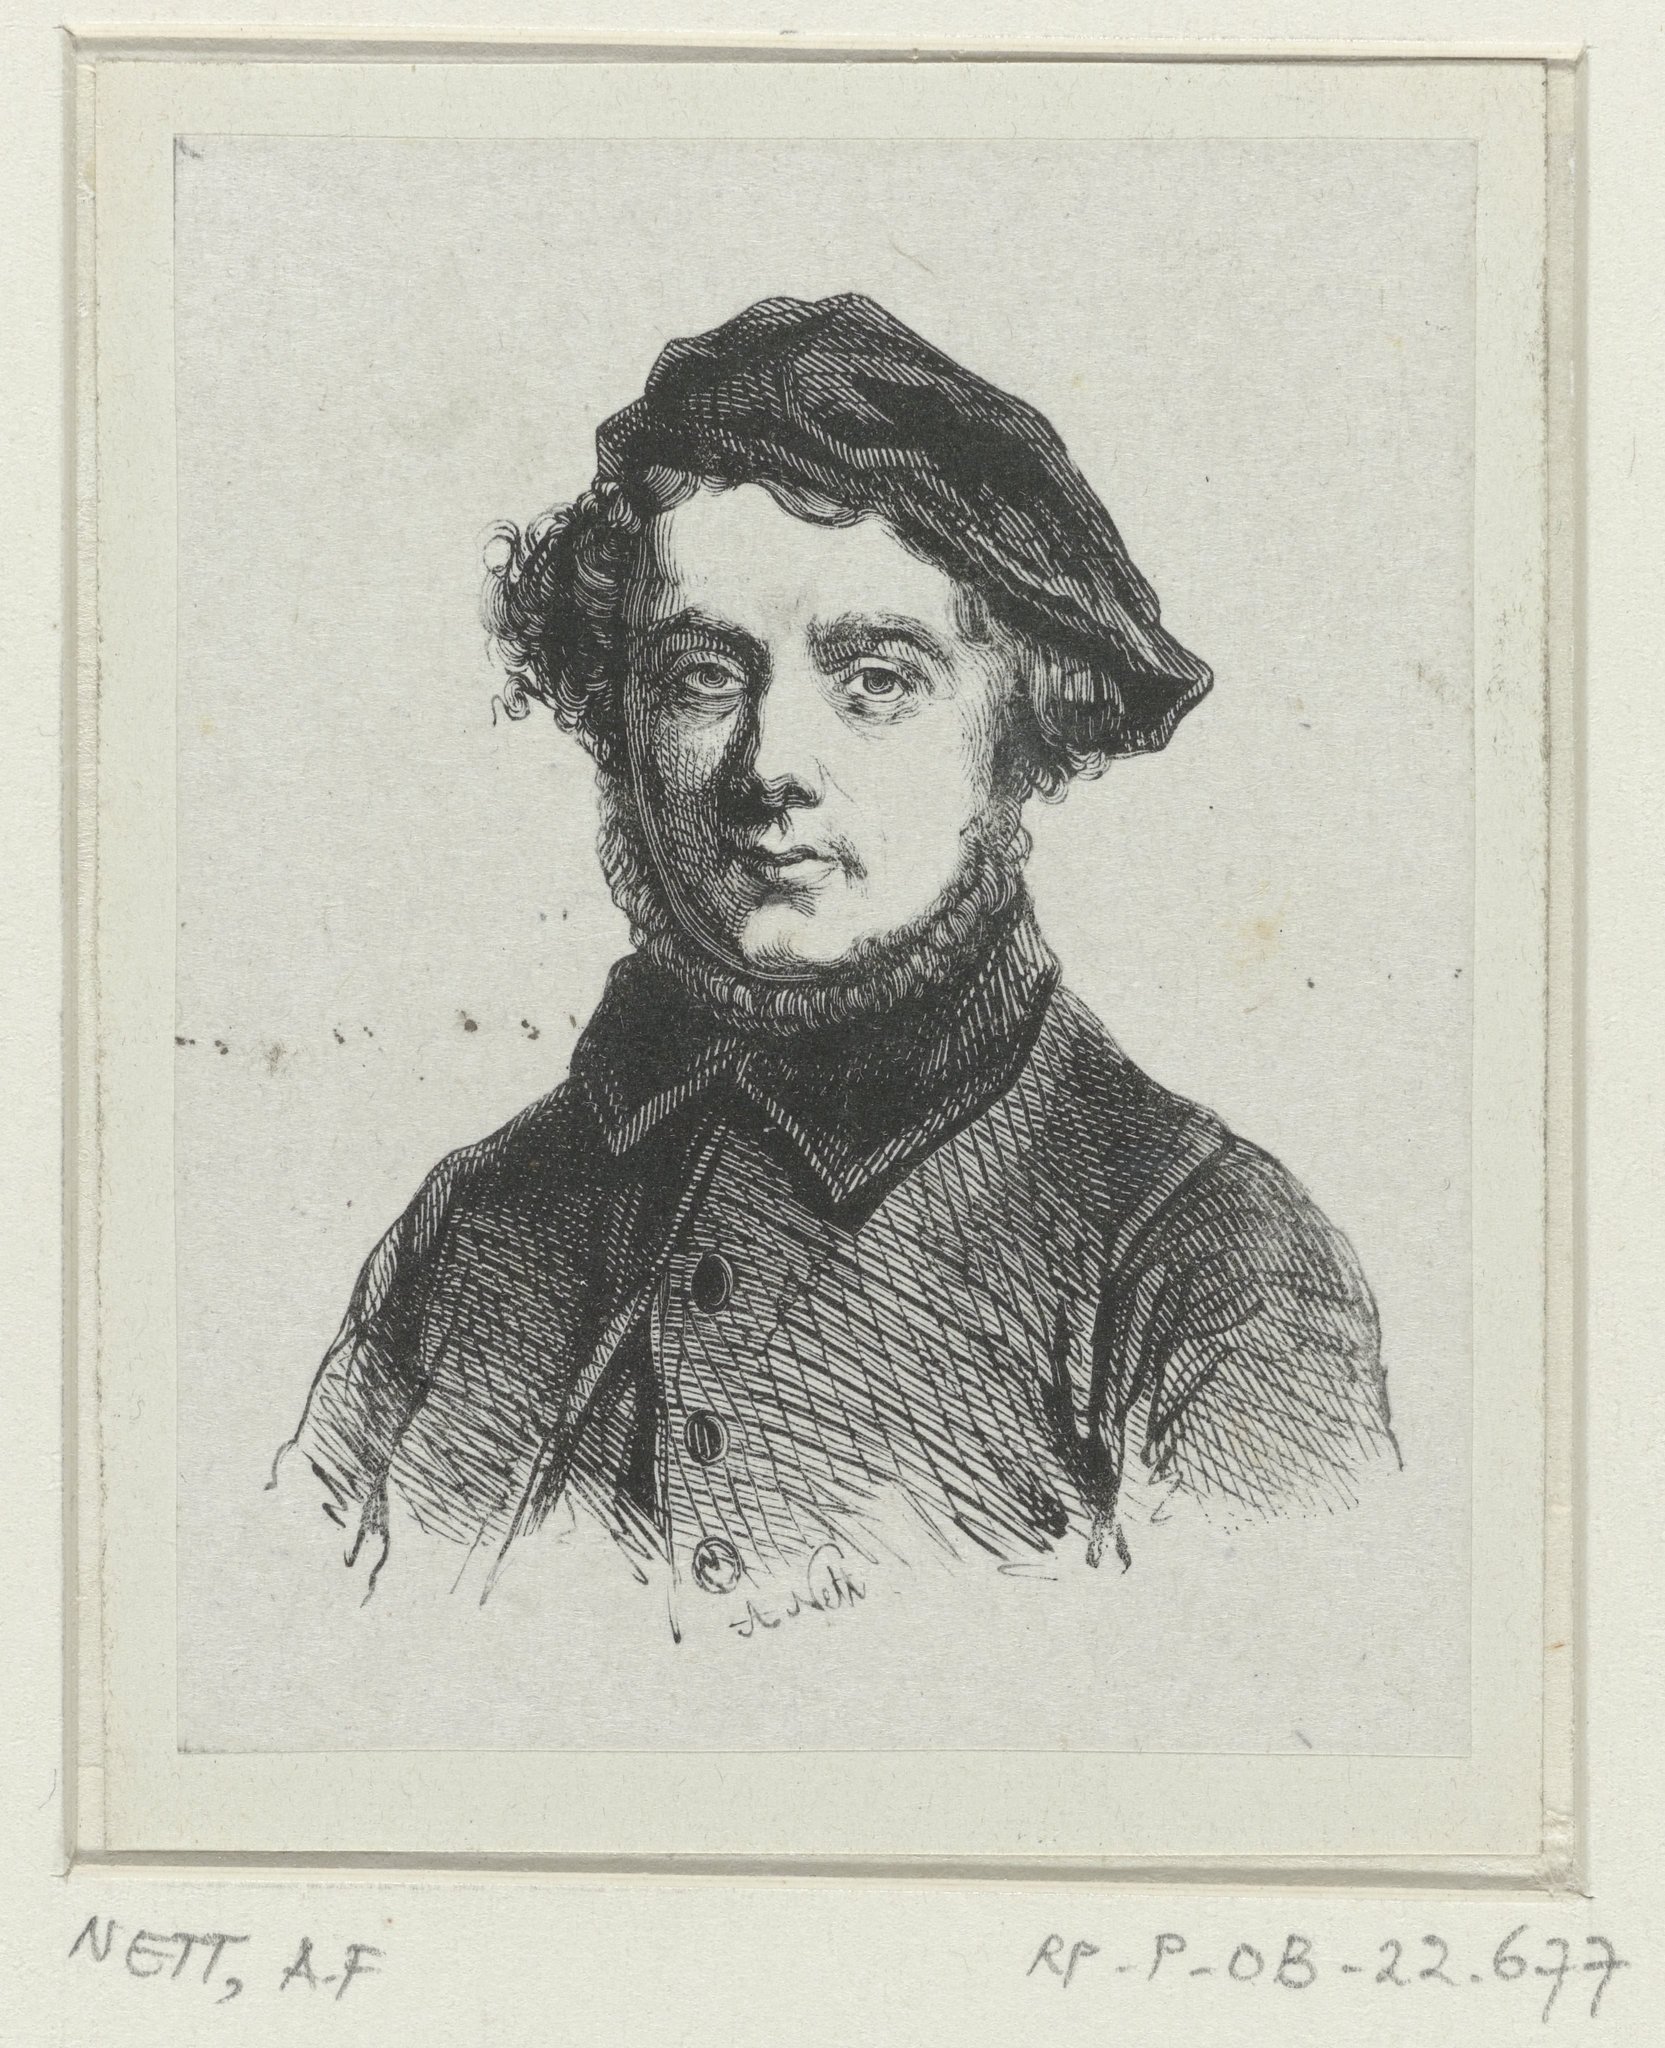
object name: print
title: Portret van de schilder Charles Ferdinand Venneman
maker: adolphe frédéric nett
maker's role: print maker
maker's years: 1822-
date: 1832-1900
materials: paper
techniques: engraving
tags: draughtsman, charles venneman, historical persons, portrait, self-portrait of painter, portrait, self-portrait of artist